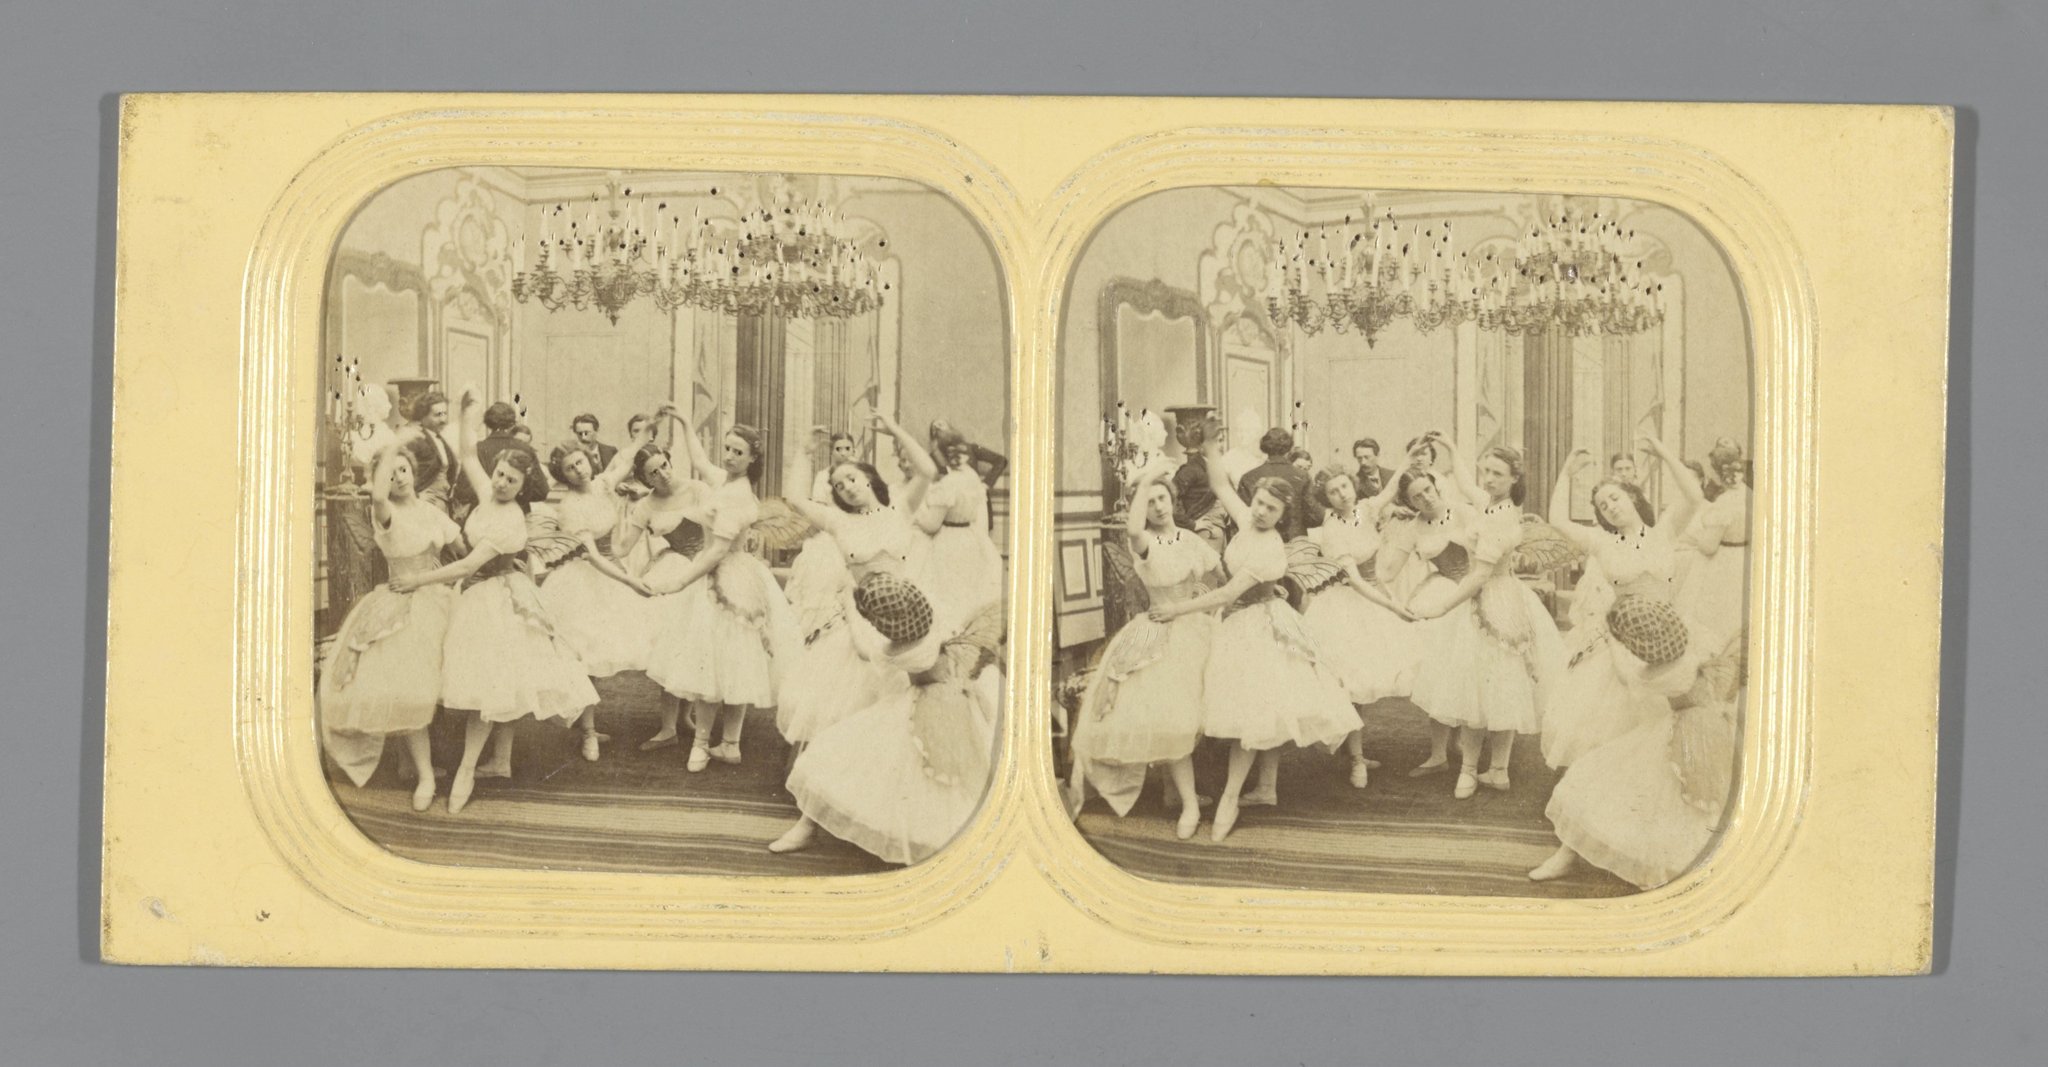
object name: tissue stereograph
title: Balletdansers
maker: Anonymous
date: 1855-1875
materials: cardboard, paper, photographic support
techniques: albumen print, cutting, hand coloring, perforating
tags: the ballet, ballet performance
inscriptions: retailer's mark: ‘D. WAKKER/ Kalverstraat/ bij de Heiligenweg D 133’, inscription: ‘f 1.25’